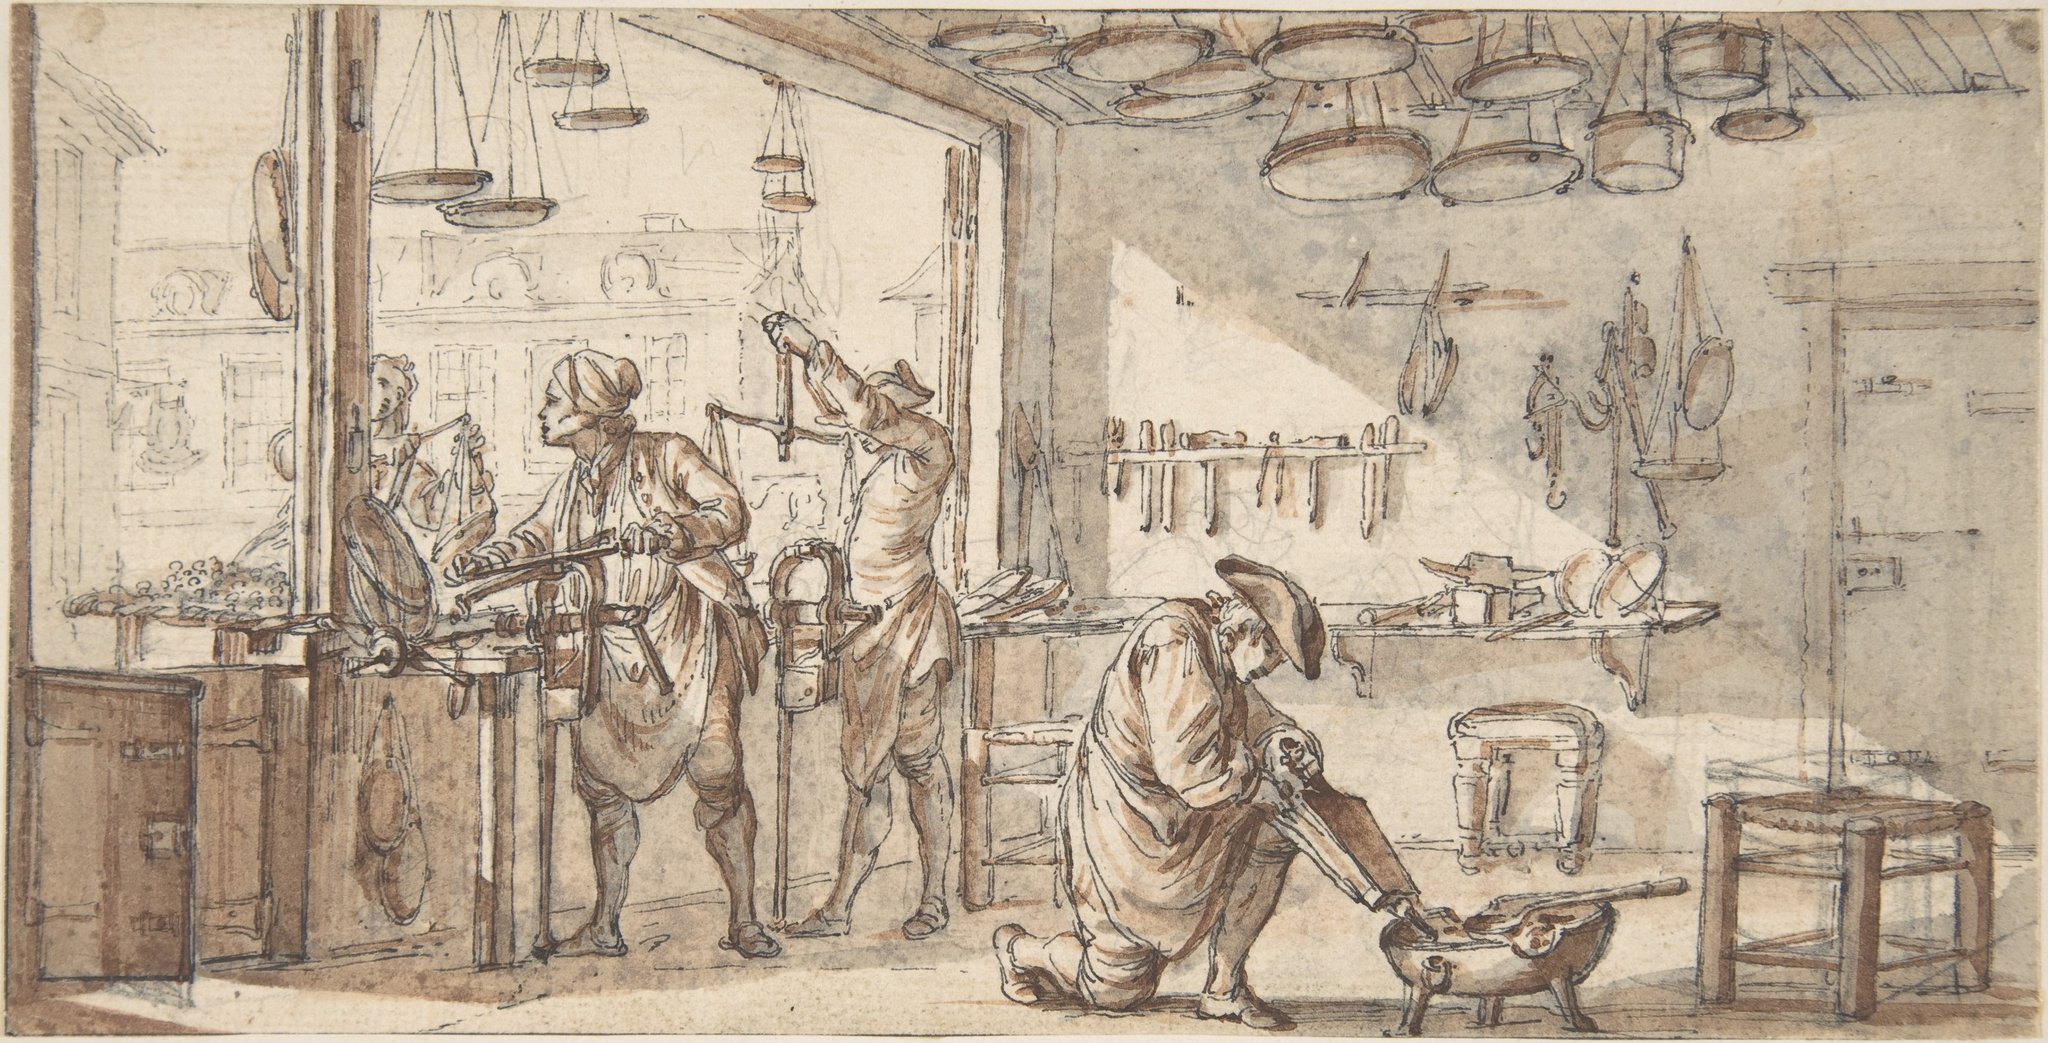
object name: drawing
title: The Maker of Scales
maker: jean michel moreau le jeune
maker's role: artist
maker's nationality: french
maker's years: 1741-1814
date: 1763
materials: graphite, ink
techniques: brush, pen, wash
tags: men,working,scales